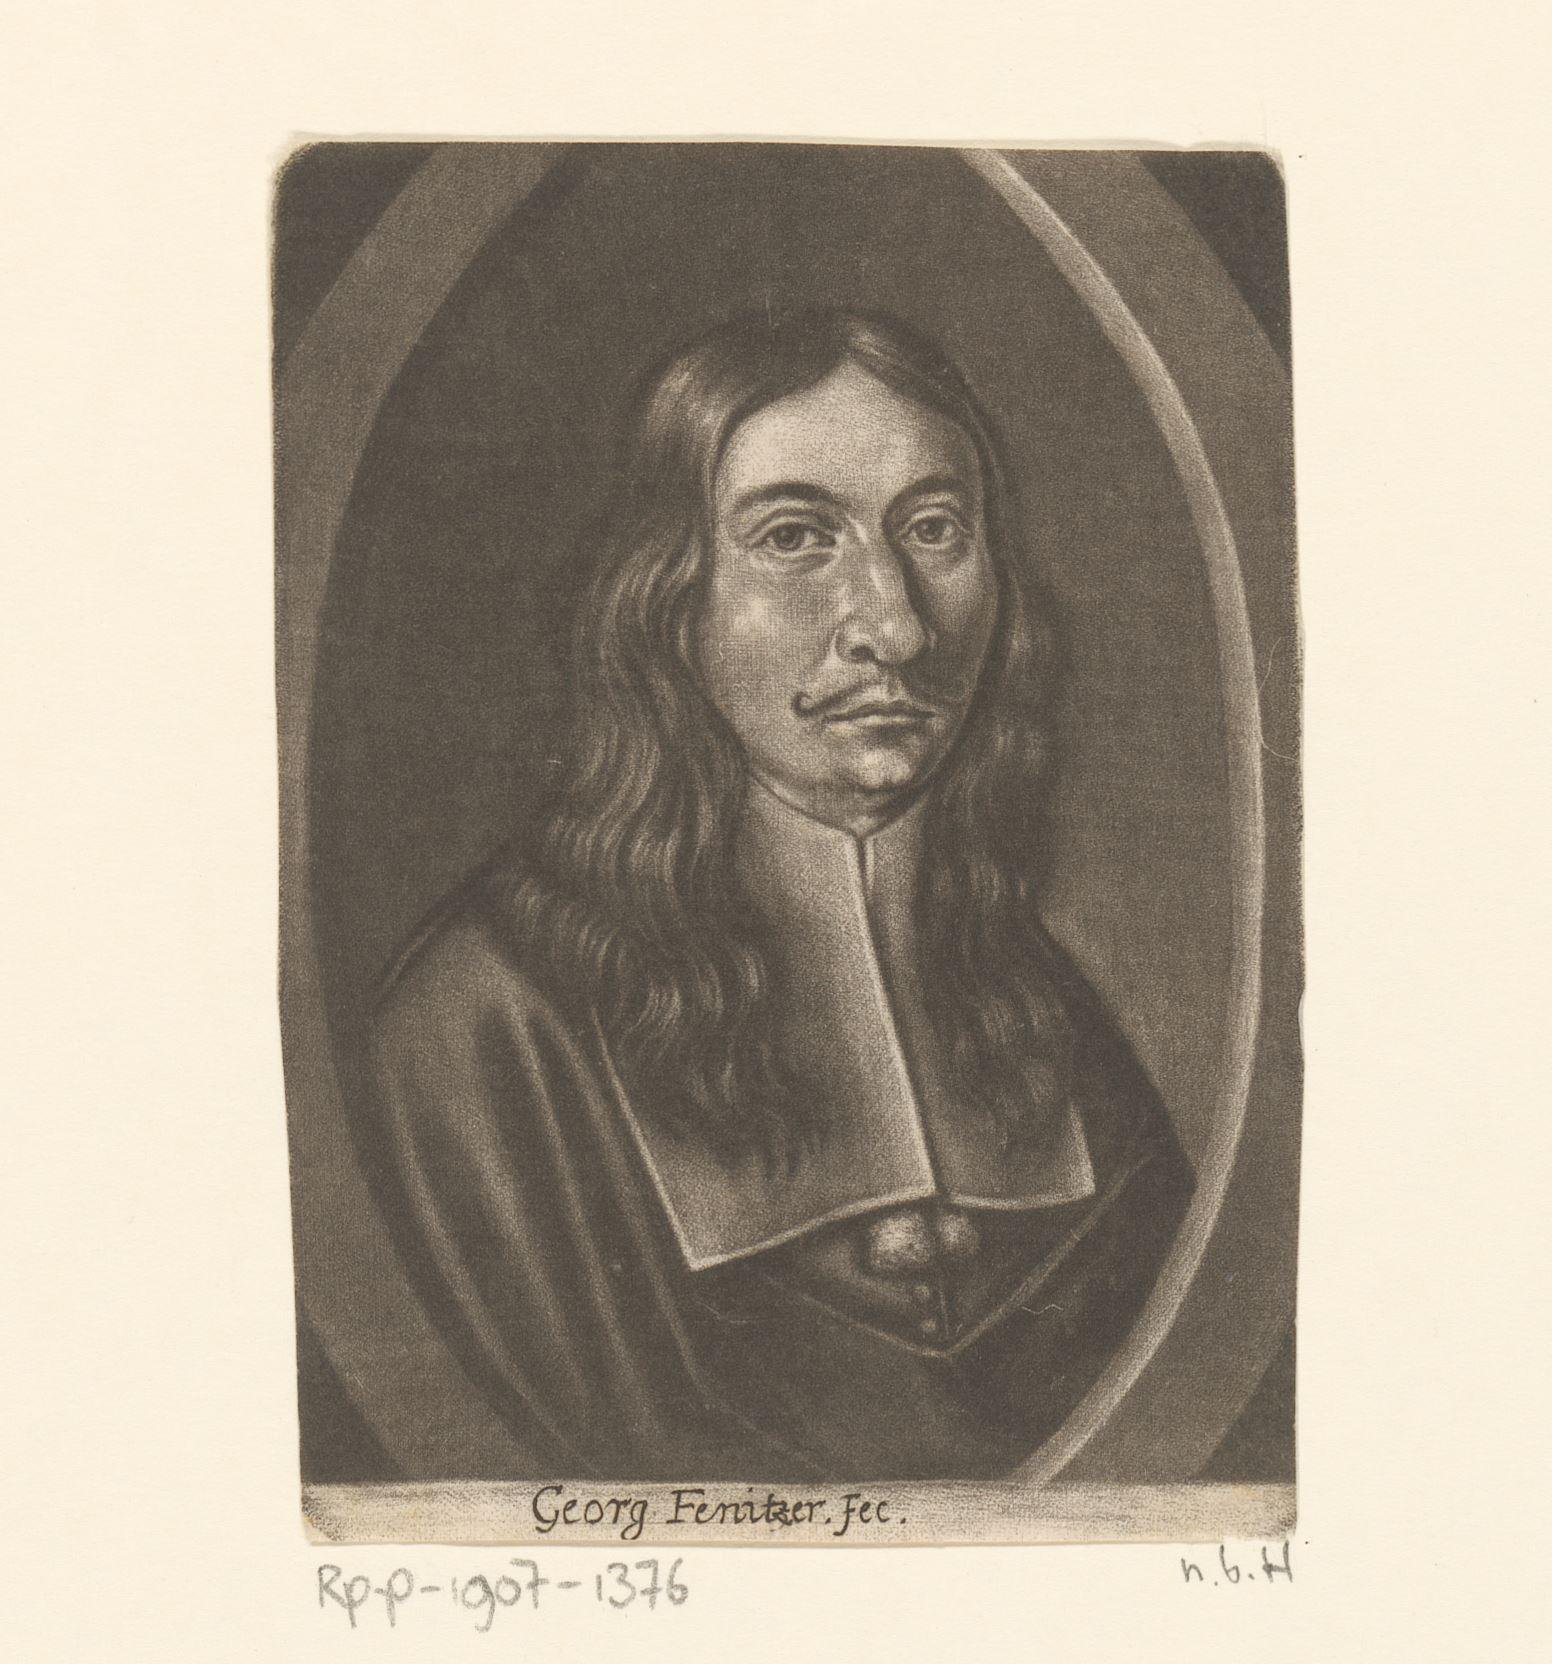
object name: print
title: Zelfportret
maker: georg fennitzer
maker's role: print maker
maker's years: 1646-1722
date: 1656-1722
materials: paper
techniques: mezzotint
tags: print maker, georg fennitzer, portrait, self-portrait of artist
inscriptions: collector's mark: Lugt 2228